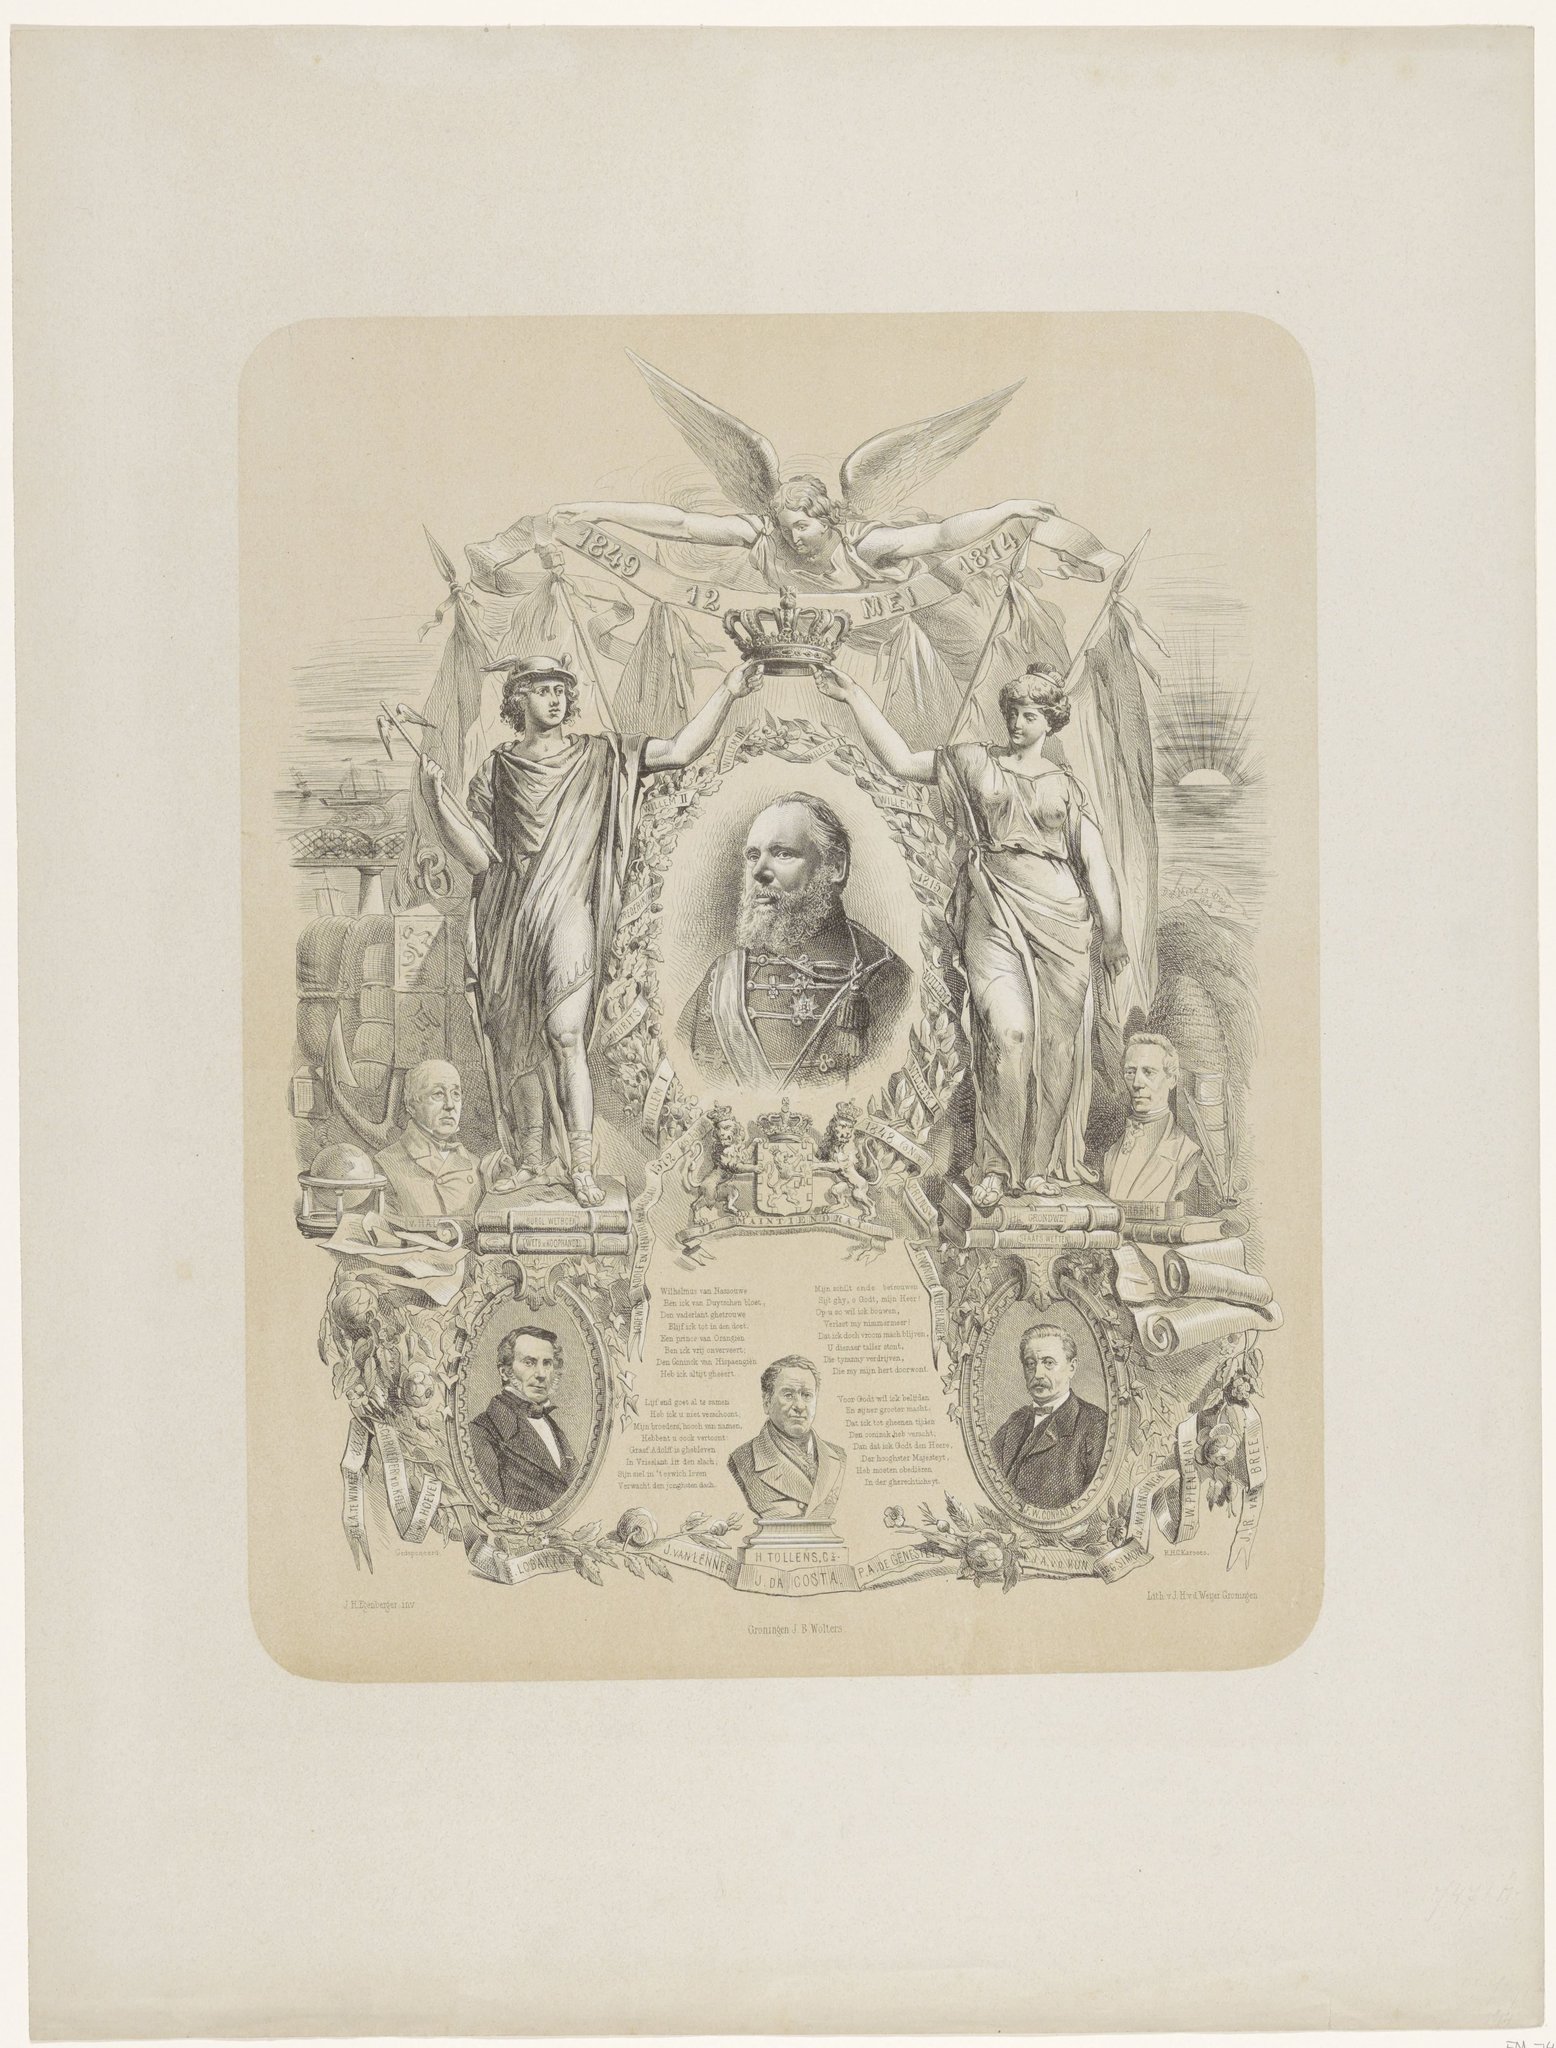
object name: print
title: Gedenkplaat bij het 25-jarige regeringsjubileum van koning Willem III 1849-1874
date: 1874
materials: paper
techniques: tone lithography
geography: netherlands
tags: hendrik tollens, frederik willem conrad (ii), brussels, willem iii (koning der nederlanden), the hague, johan rudolf thorbecke, frederik kaiser, amsterdam, floris adriaan van hall, historical persons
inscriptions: collector's mark: Lugt 2228, : ‘Gedeponeerd’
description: Gedenkplaat bij de viering van het 25-jarige regeringsjubileum van koning Willem III, 12 mei 1874. Centraal een portret van de koning gekroond door Mercurius en de Nederlandse Maagd. Met portretten van de ministers Van Hall, Thorbecke en van de wetenschappers F. Kaiser en F.W. Conrad. Onderaan vier coupletten uit het Wilhelmus en een buste van de dichter Tollens.